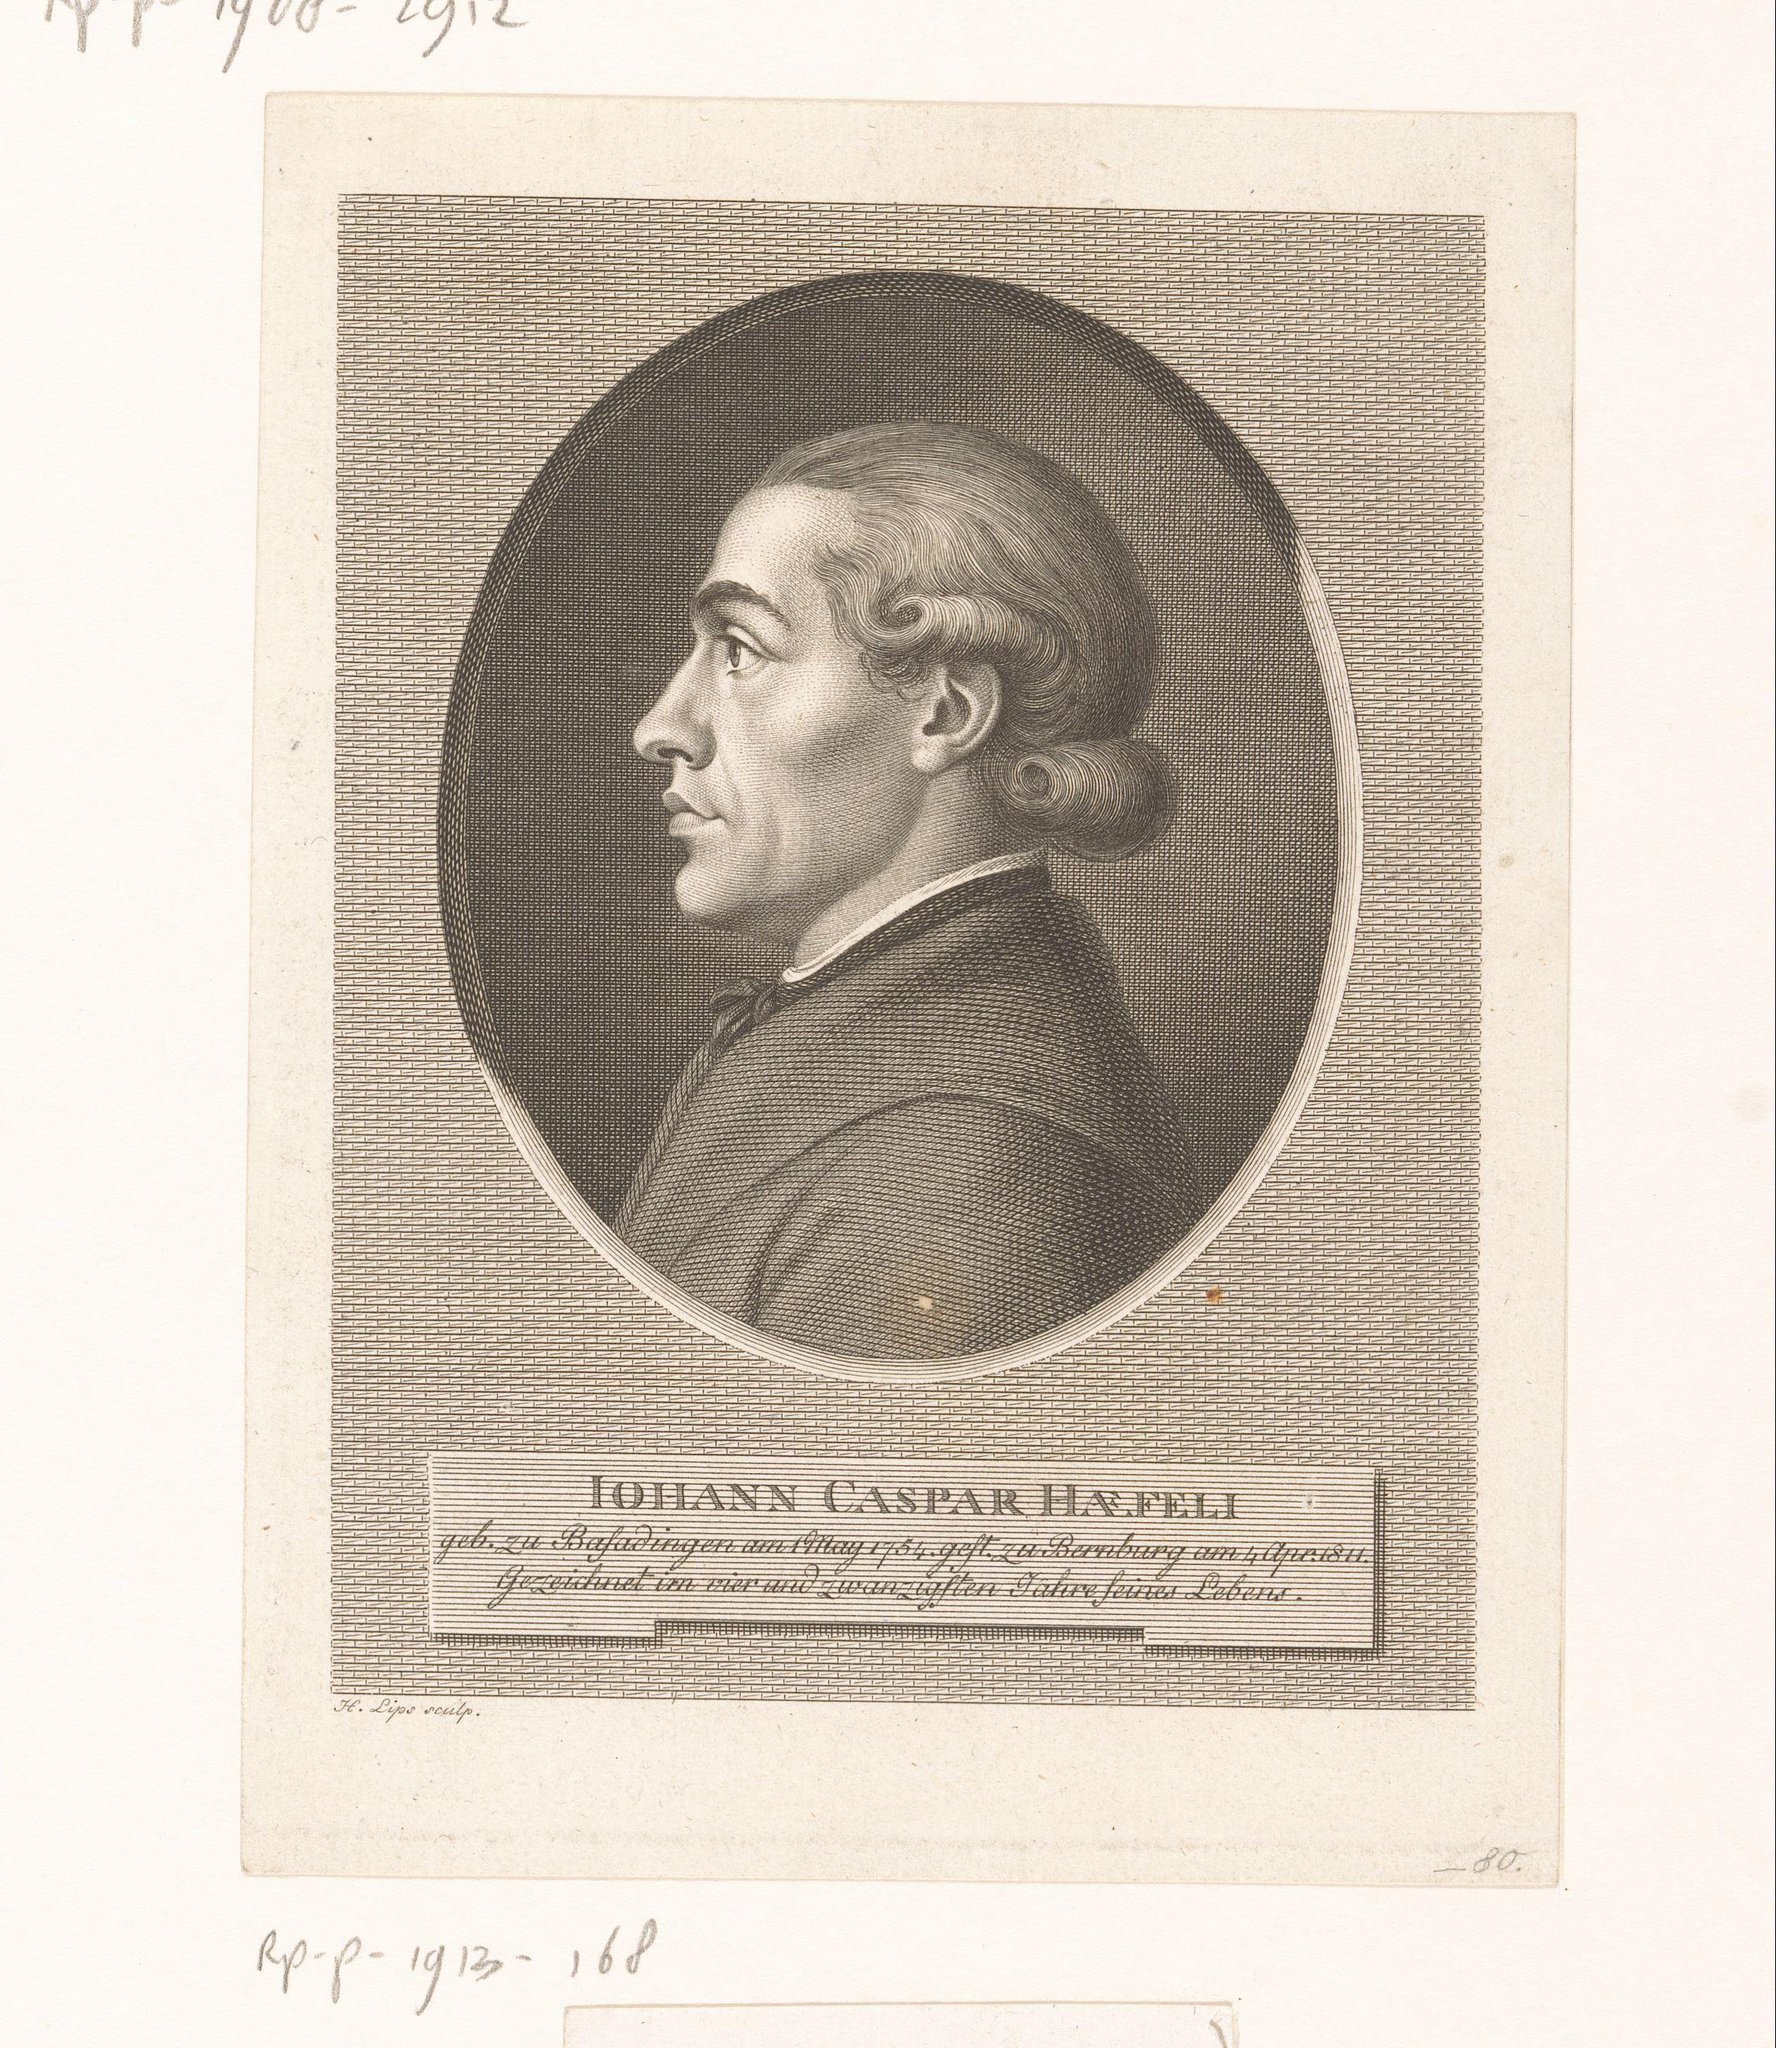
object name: print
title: Portret van Johann Caspar Haefeli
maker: johann heinrich lips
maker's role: draughtsman, painter, print maker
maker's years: 1758-1817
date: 1811-1833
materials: paper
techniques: engraving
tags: theologian, historical persons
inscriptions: collector's mark: Lugt 2228